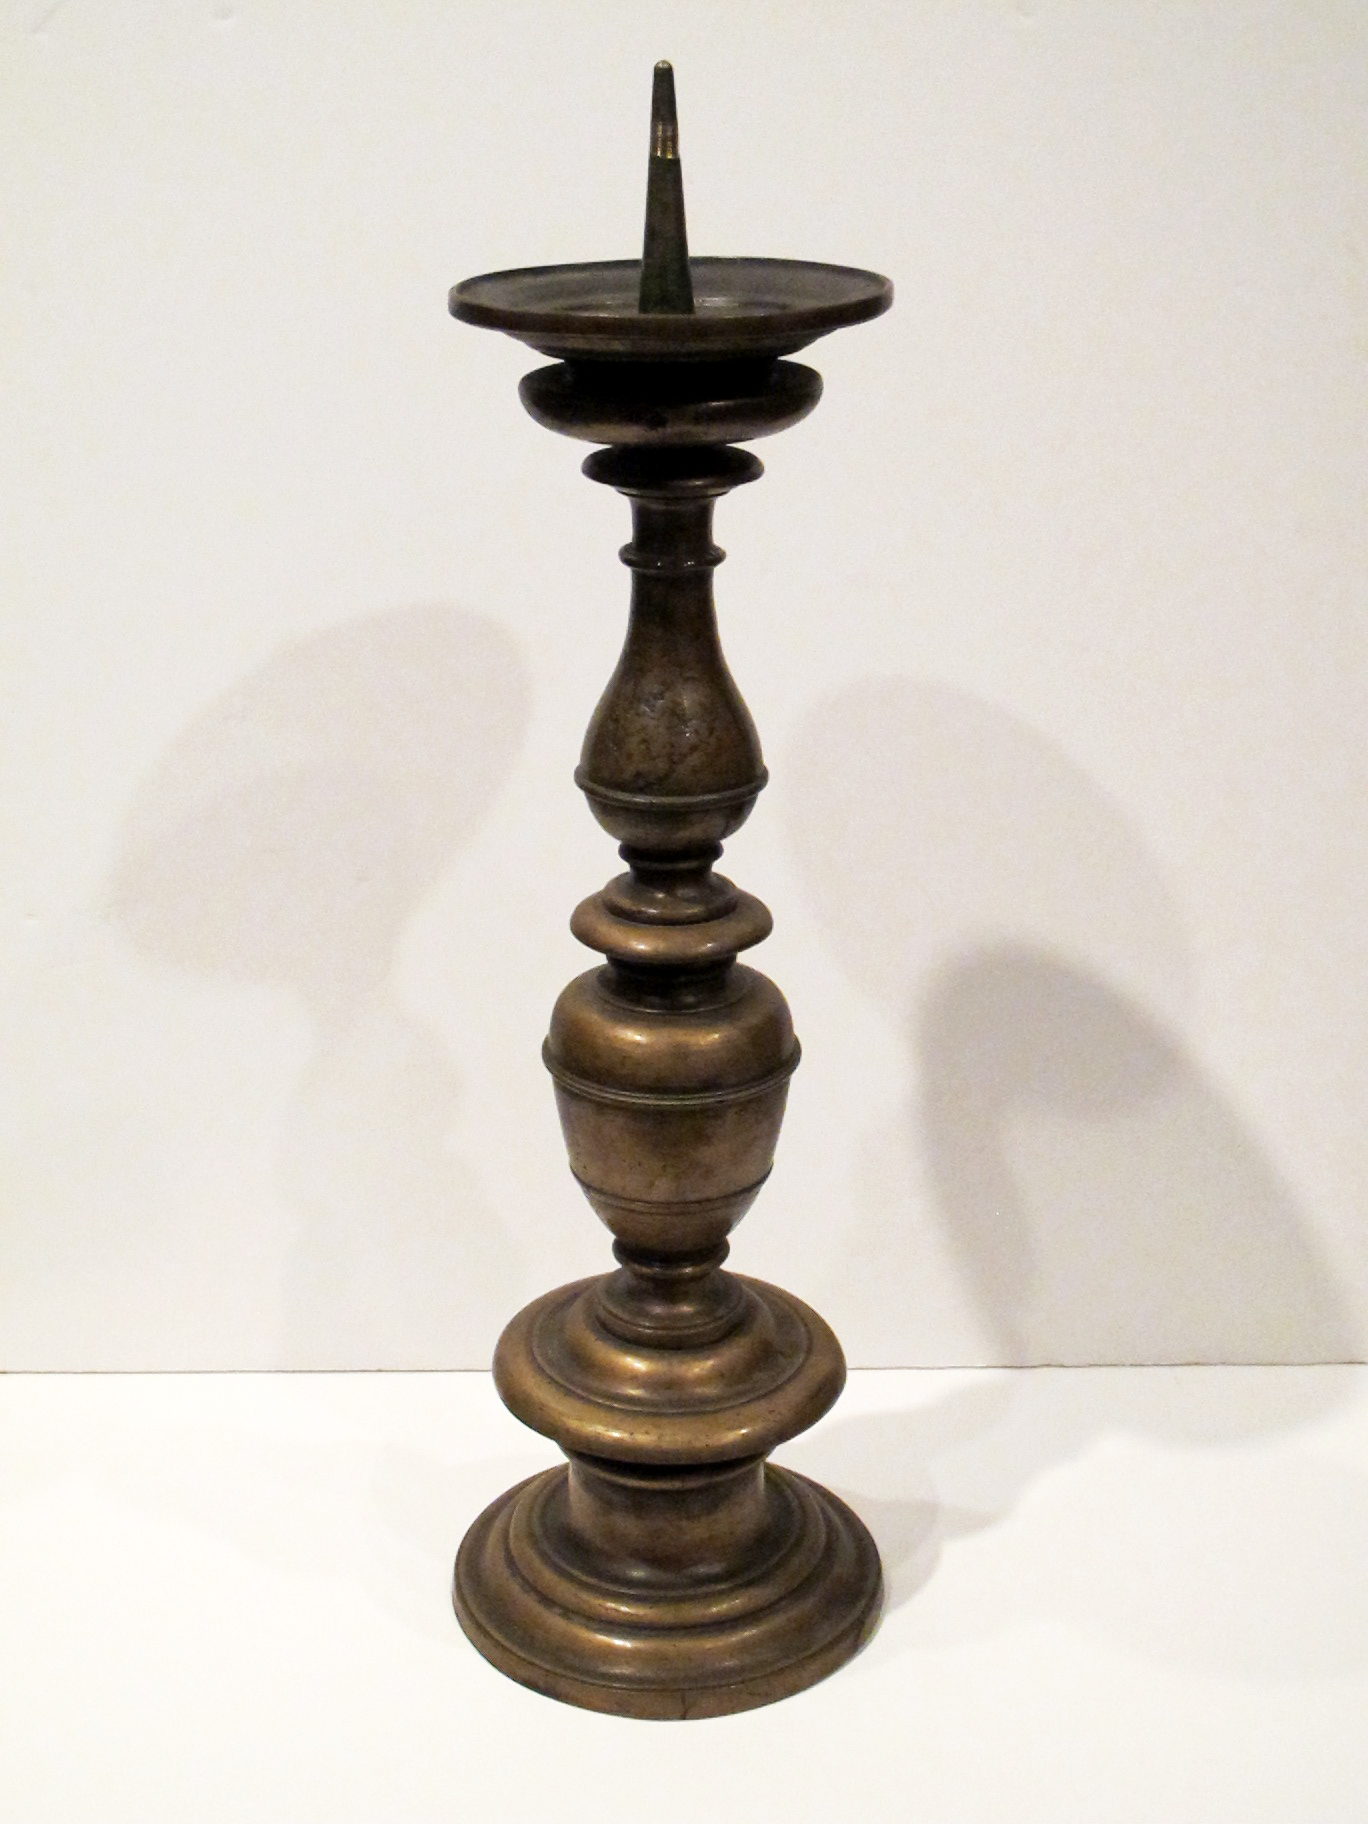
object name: candlestick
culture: european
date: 1801-1900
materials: copper alloy